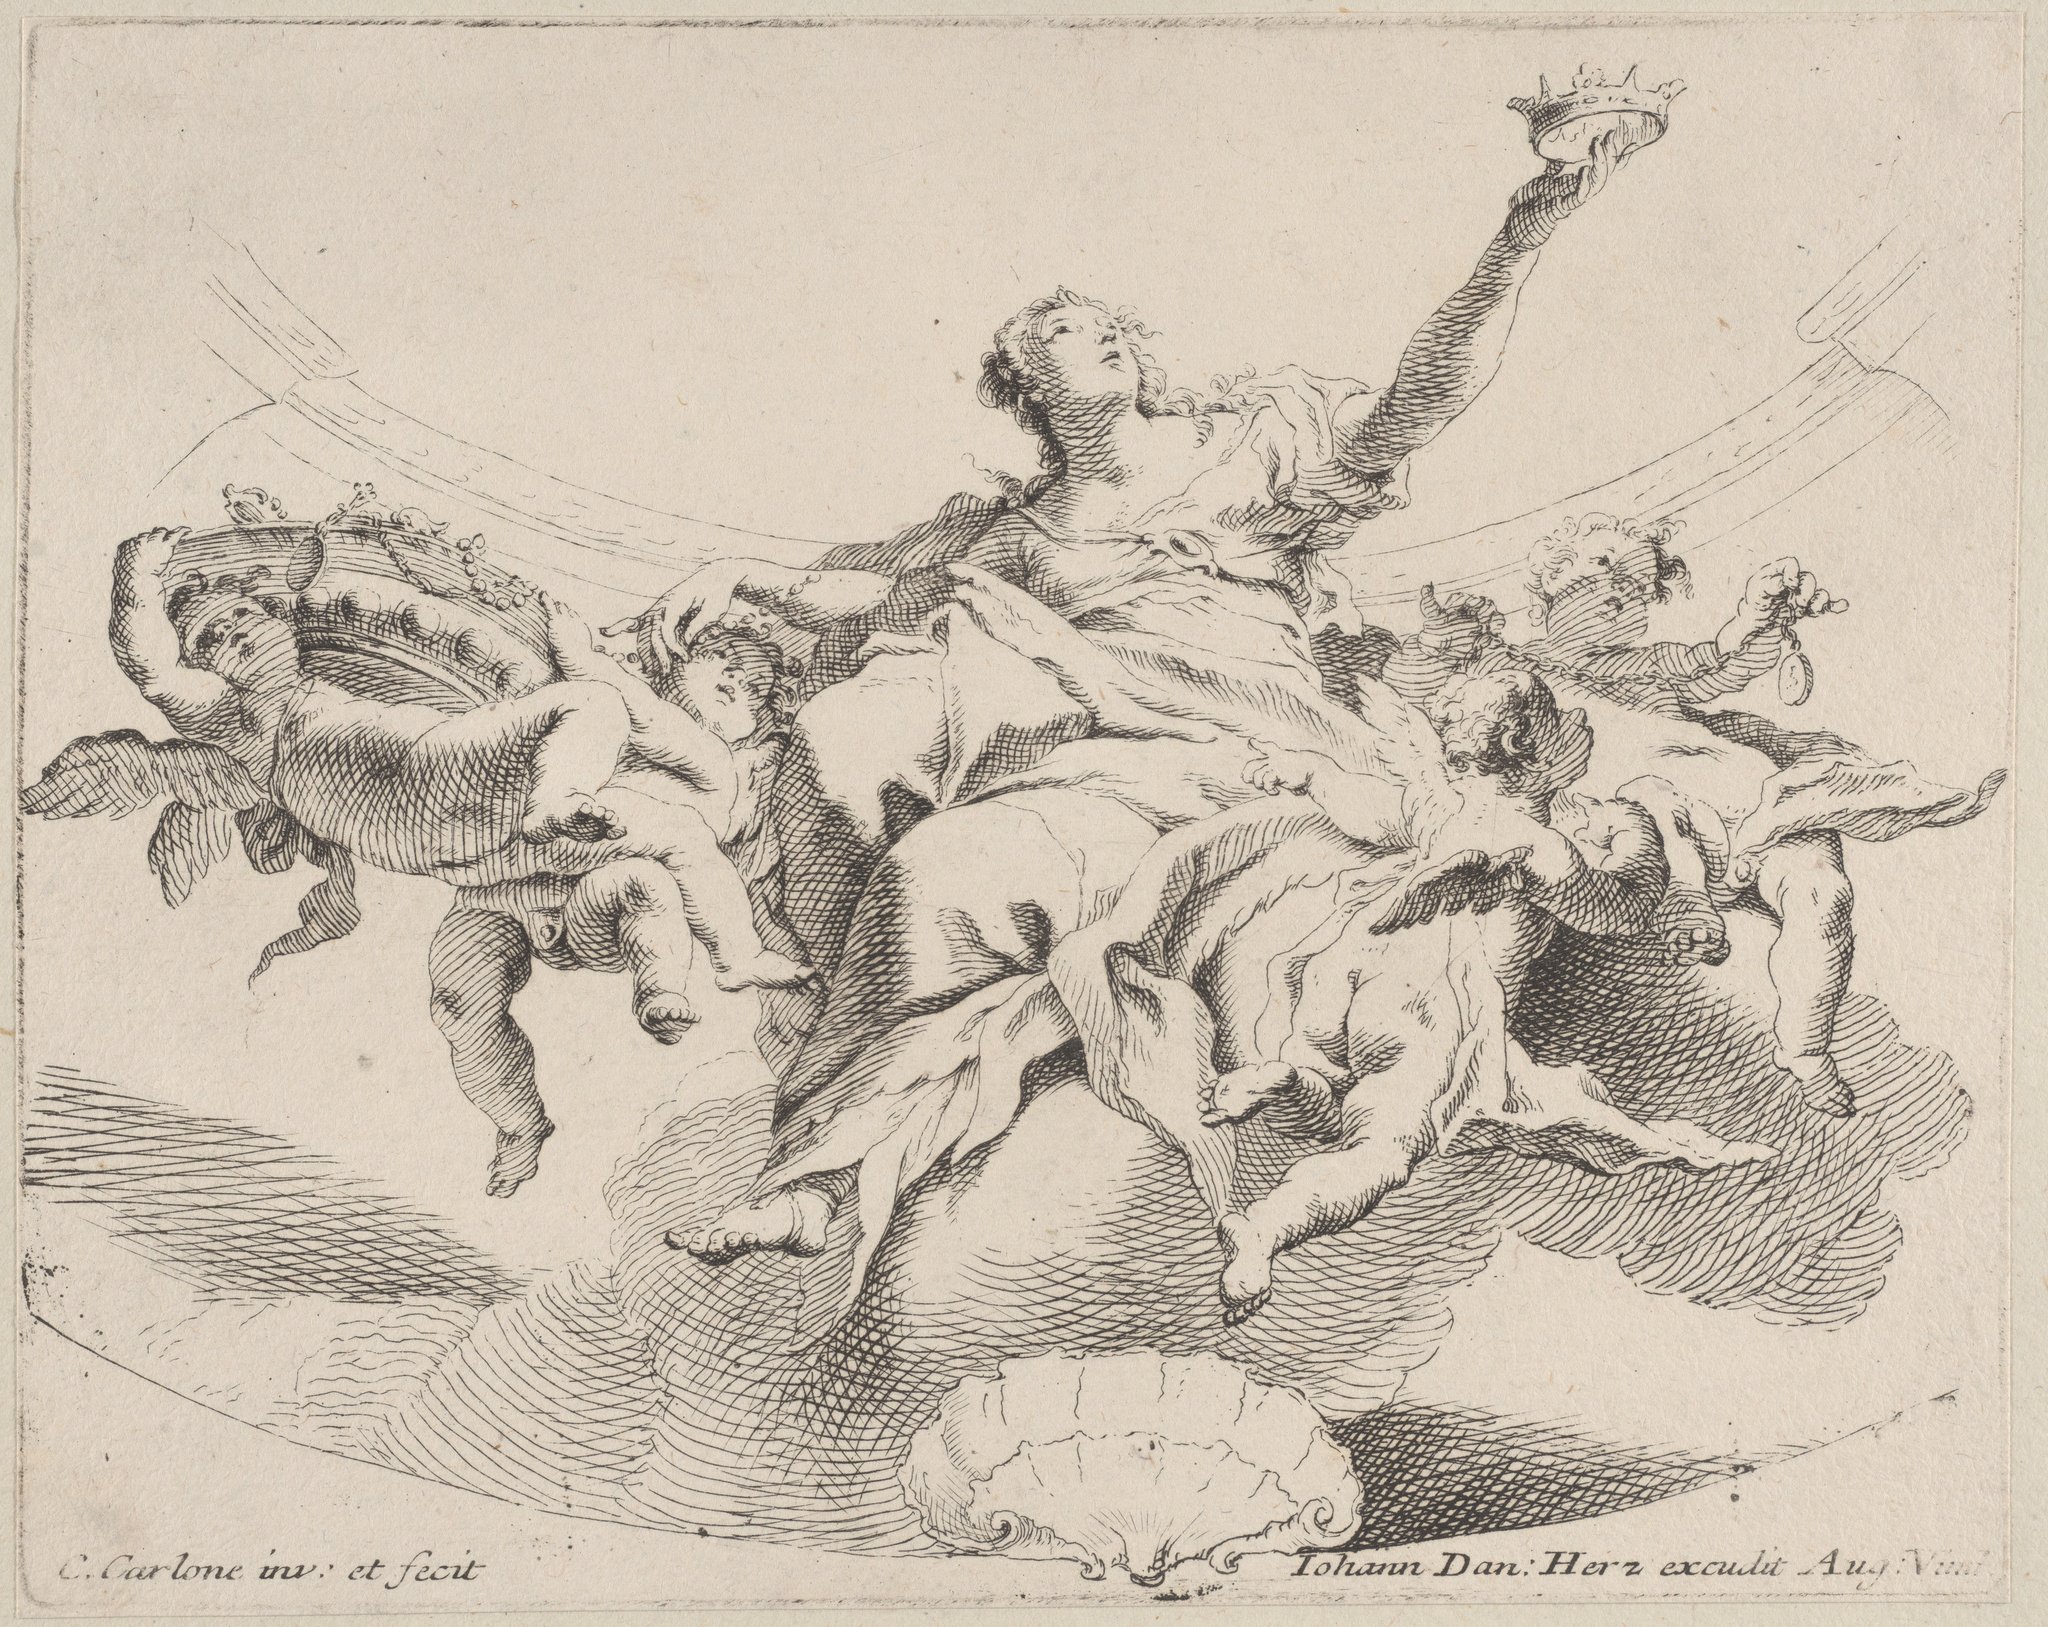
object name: print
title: Power, represented by a woman seated on clouds holding a crown and surrounded by putti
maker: carlo innocenzo carloni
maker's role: artist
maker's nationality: italian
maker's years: 1686-1775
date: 1725-1775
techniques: etching